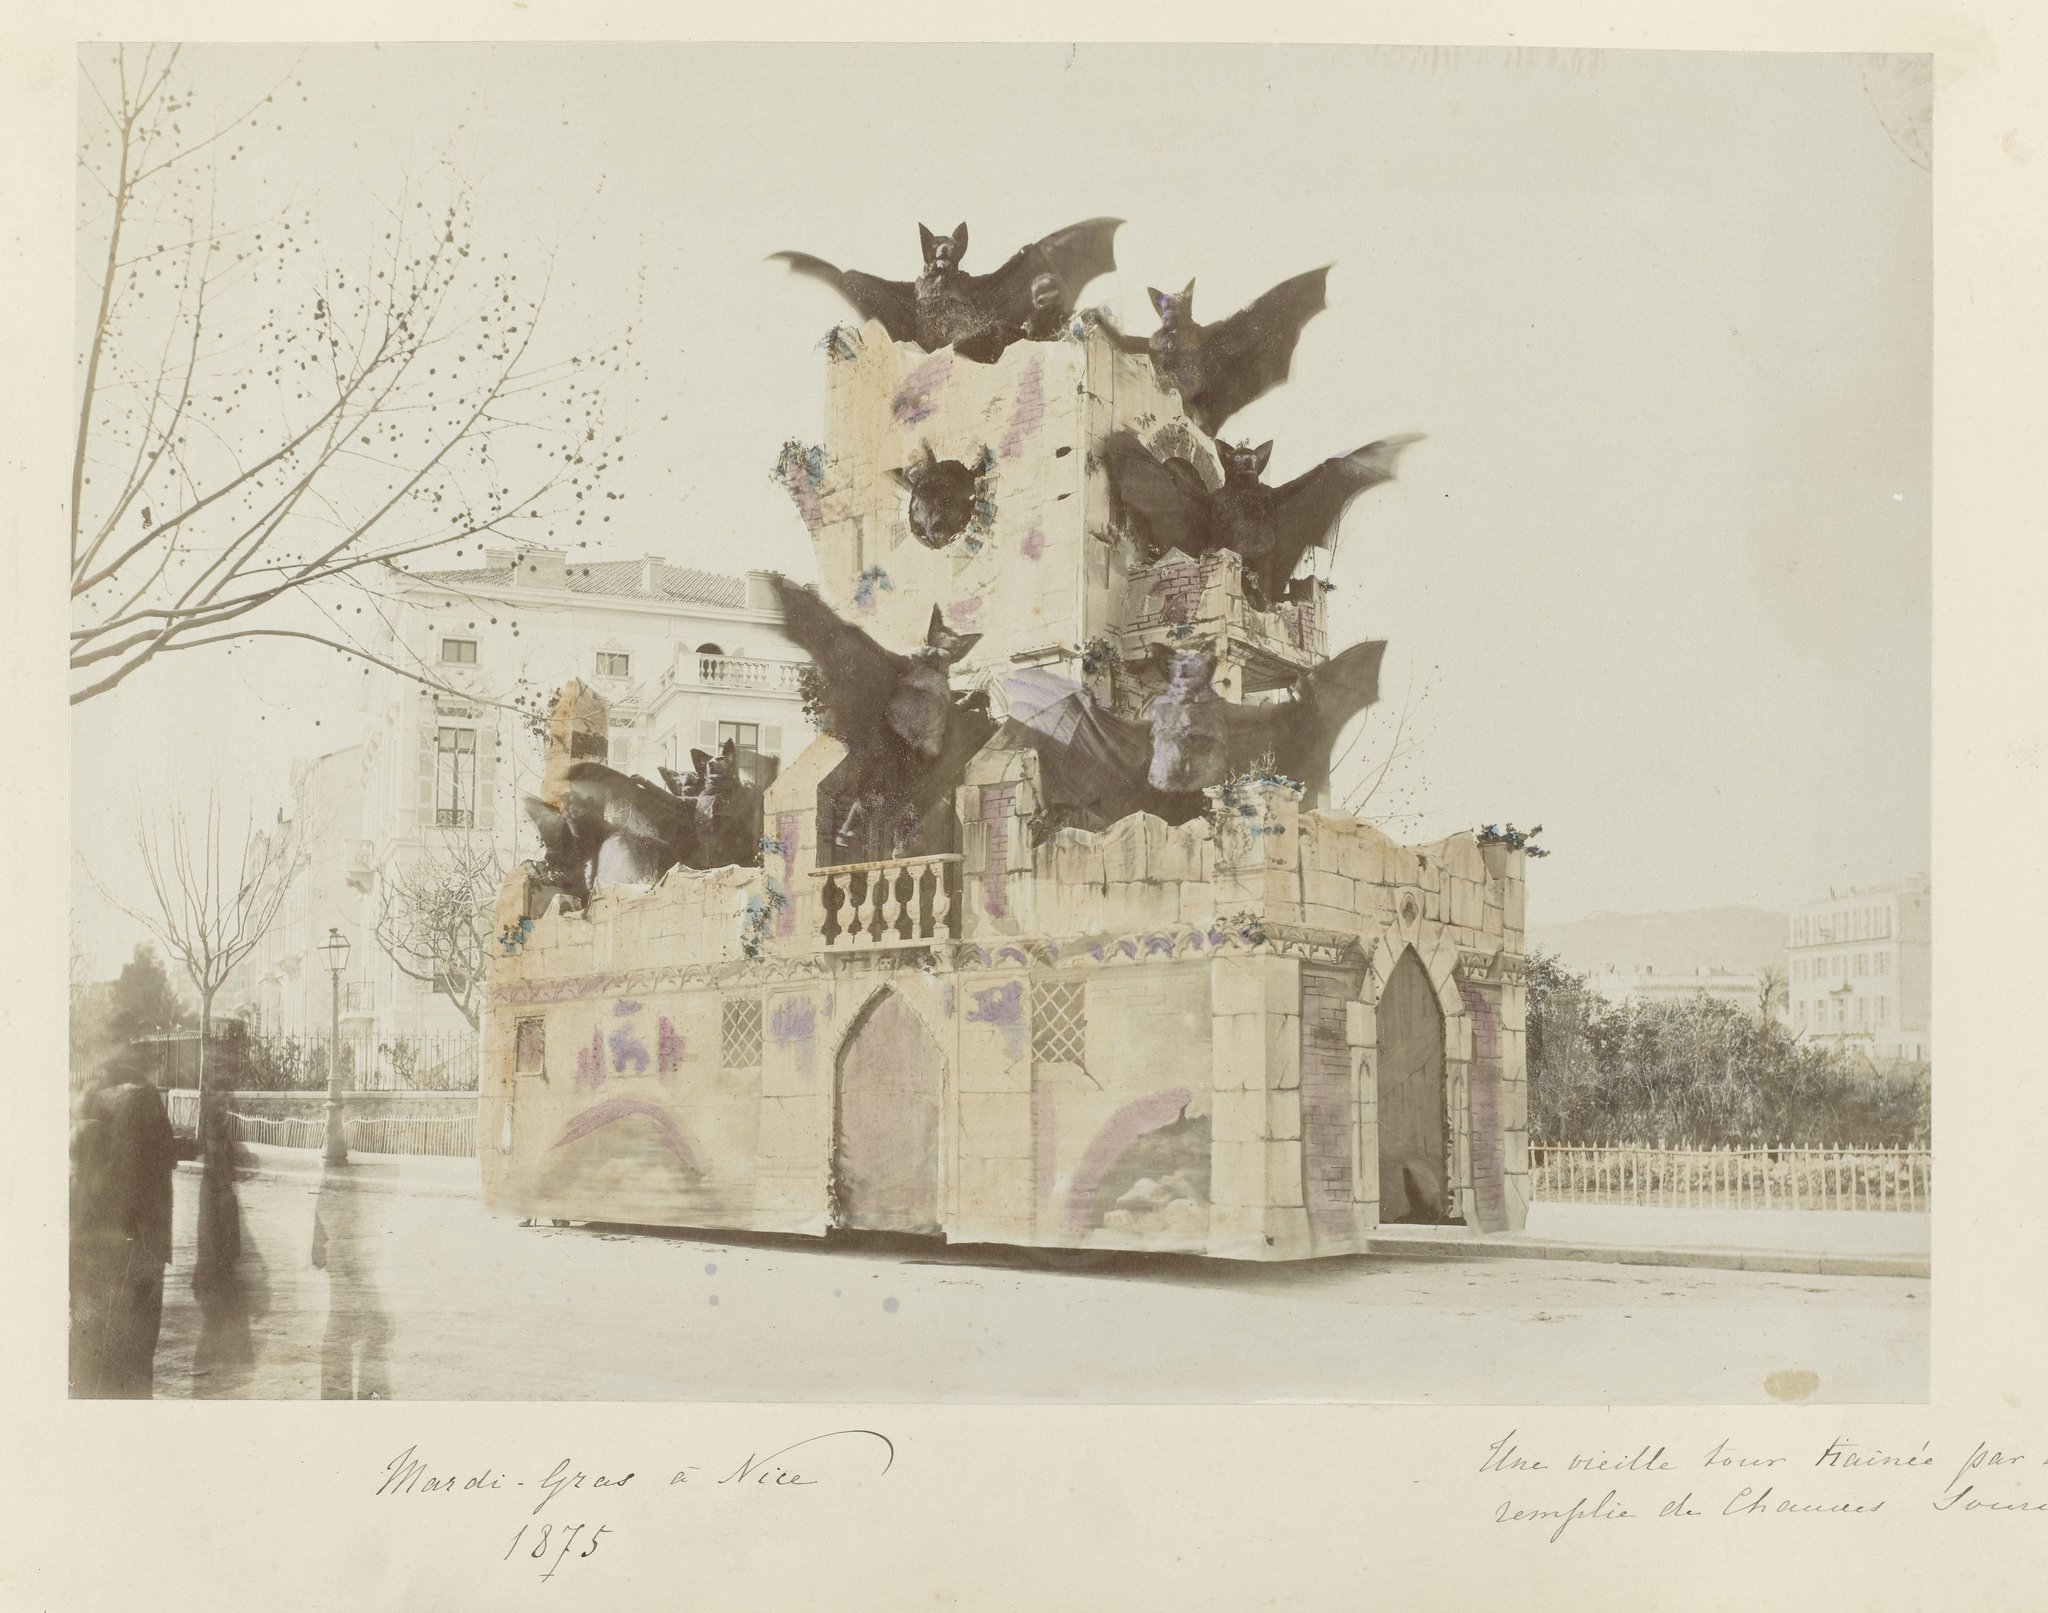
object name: photograph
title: Praalwagen met toren en vleermuizen tijdens Mardi Gras in Nice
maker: Anonymous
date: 1875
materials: photographic support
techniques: albumen print, hand coloring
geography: nice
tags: flying mammals: bat, festivities (+ parade, pageant, cavalcade ~ festive activities), carnival, shrovetide (non-liturgical celebration)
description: Onderdeel van Reisalbum met opnames van kunstwerken, personen en bezienswaardigheden in Spanje.